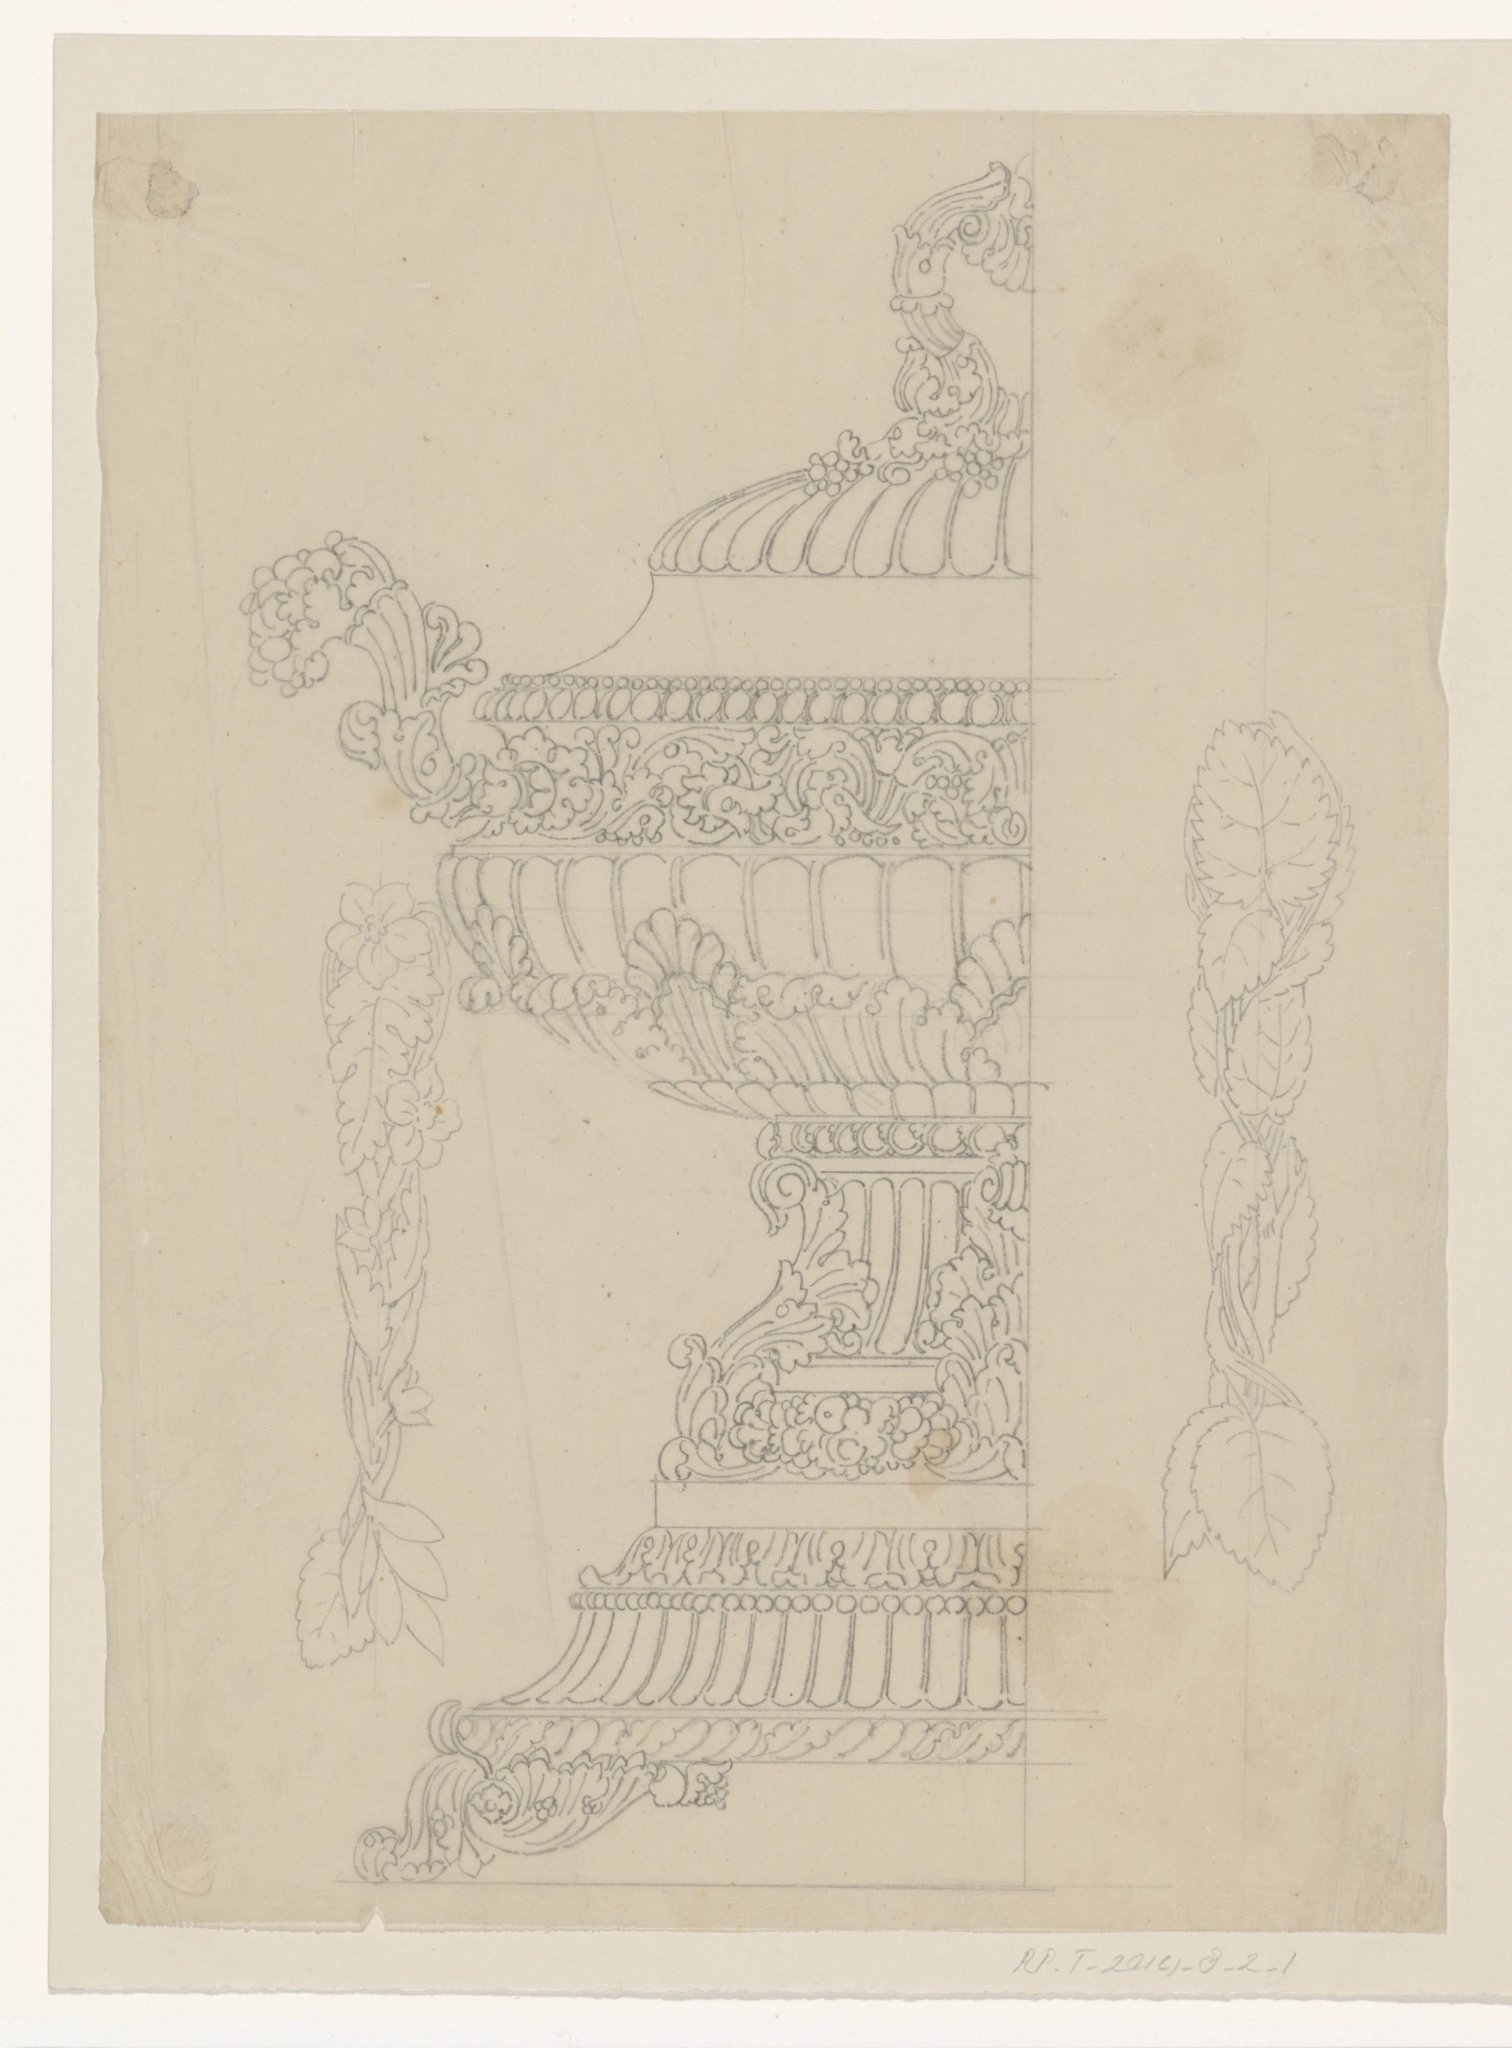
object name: design drawing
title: Ontwerp voor een dekselcoupe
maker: charles nicolas odiot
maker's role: jeweler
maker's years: 1789-1869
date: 1825-1830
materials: graphite, paper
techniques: drawing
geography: paris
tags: containers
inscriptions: stamp